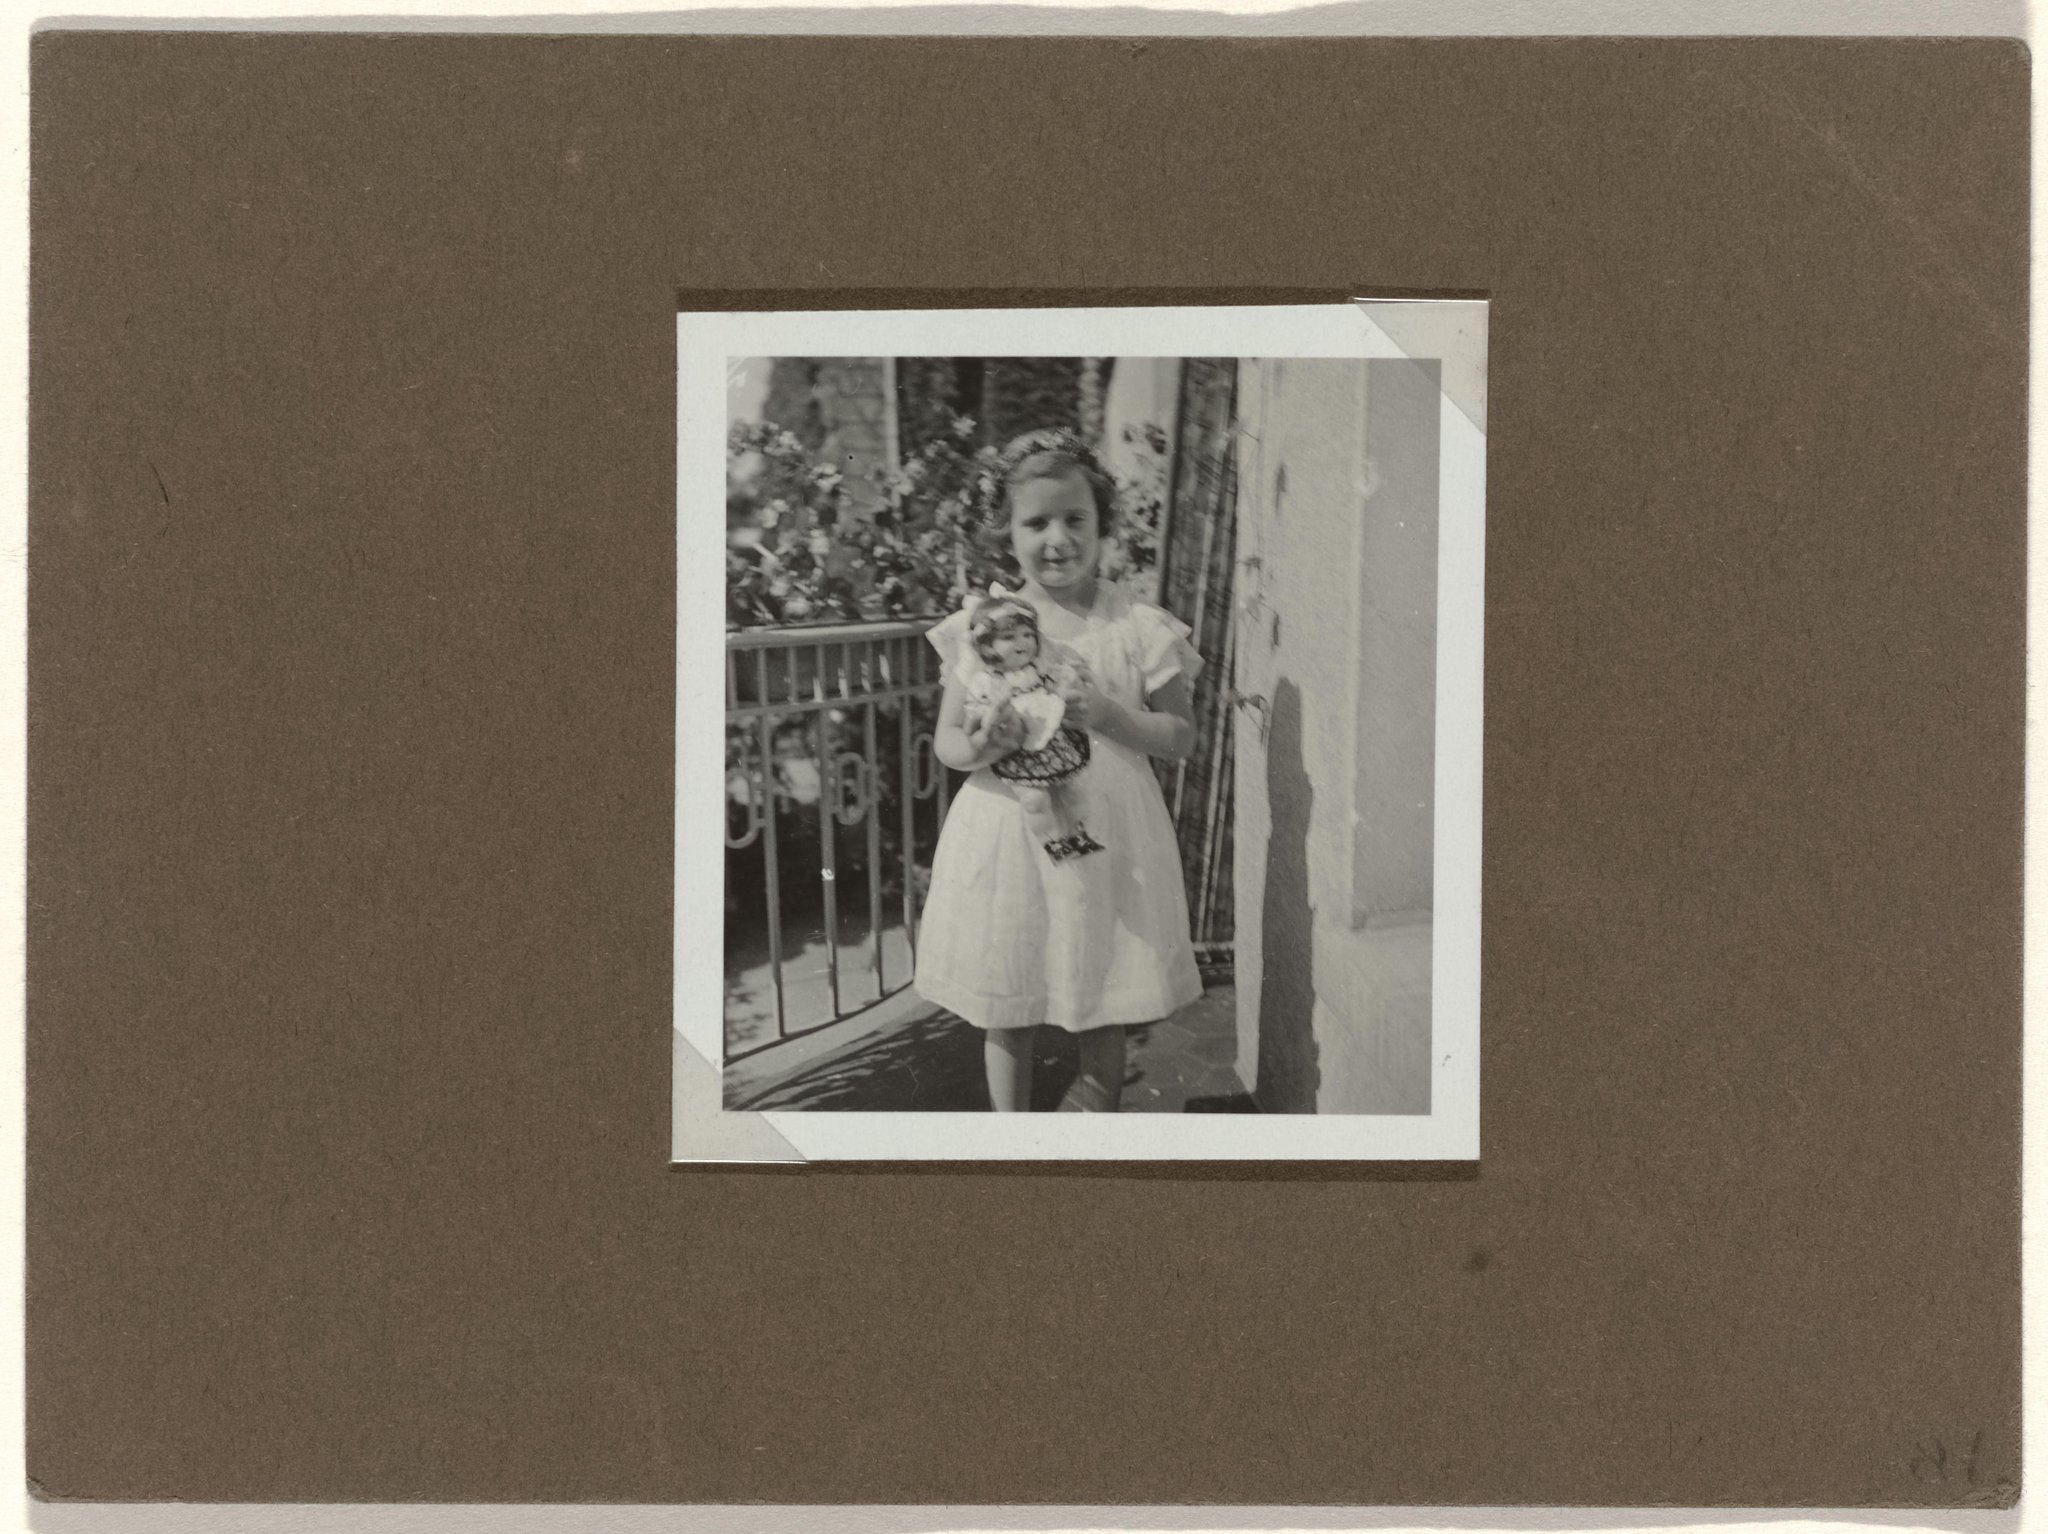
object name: photograph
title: Isabel Wachenheimer tijdens haar verjaardag met pop in de hand op balkon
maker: Anonymous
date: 1932-1937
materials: photographic support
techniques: gelatin silver print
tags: leiden, isabel wachenheimer-elon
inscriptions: inscription: ‘im Garten’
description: Dit object is onderdeel van de nalatenschap van Isabel Elon-Wachenheimer (1928-2010). Tot haar overlijden behoorde het samen met de andere objecten uit de nalatenschap tot haar privédomein van Isabel Wachenheimer. In die particuliere context zijn deze objecten tezamen en individueel aandenkens - aan de jeugd, ouders en familie van Isabel Wachenheimer vóór en tijdens de Shoah en aan haar leven na de Tweede Wereldoorlog. Isabel Wachenheimer, die van juni 1943 tot mei 1945 gevangen zat in Kamp Westerbork, Theresienstadt, Auschwitz, Lenzing a/d Oberdonau (een buitenkamp van Mauthausen), overleefde de Shoah. Haar ouders – Eugène Wachenheimer en Else Wachenheimer-Moos - werden op 14 oktober 1944 in Auschwitz-Birkenau vermoord.